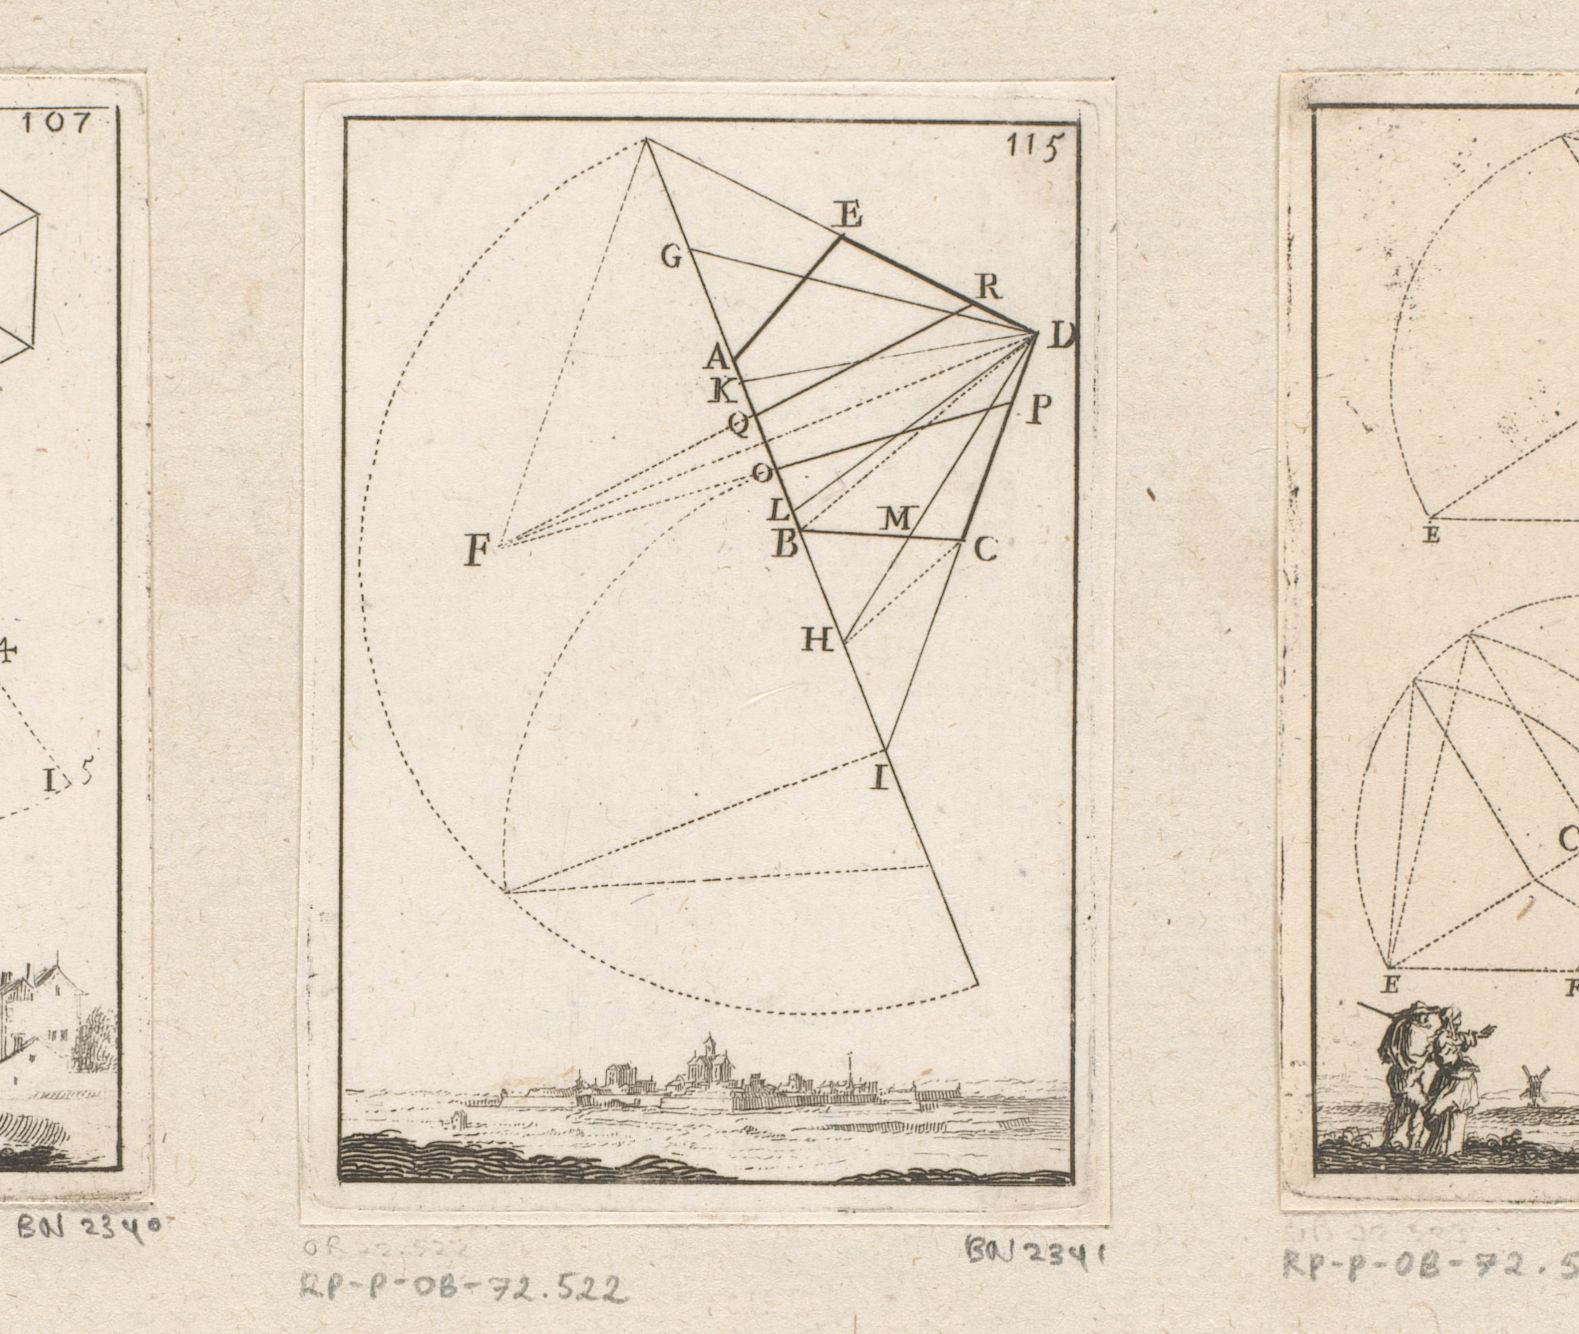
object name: print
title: Verdeling van een vijfhoek in vijf gelijke delen met onderaan een gezicht op een stad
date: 1669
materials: paper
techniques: etching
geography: france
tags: city-view in general; 'veduta', planimetry, geometry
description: Prent toegevoegd aan: Pratique de la géometrie, sur le papier et sur le terrain. Avec un nouvel ordre et une méthode particulière. Parijs: Thomas Jolly, 1669.